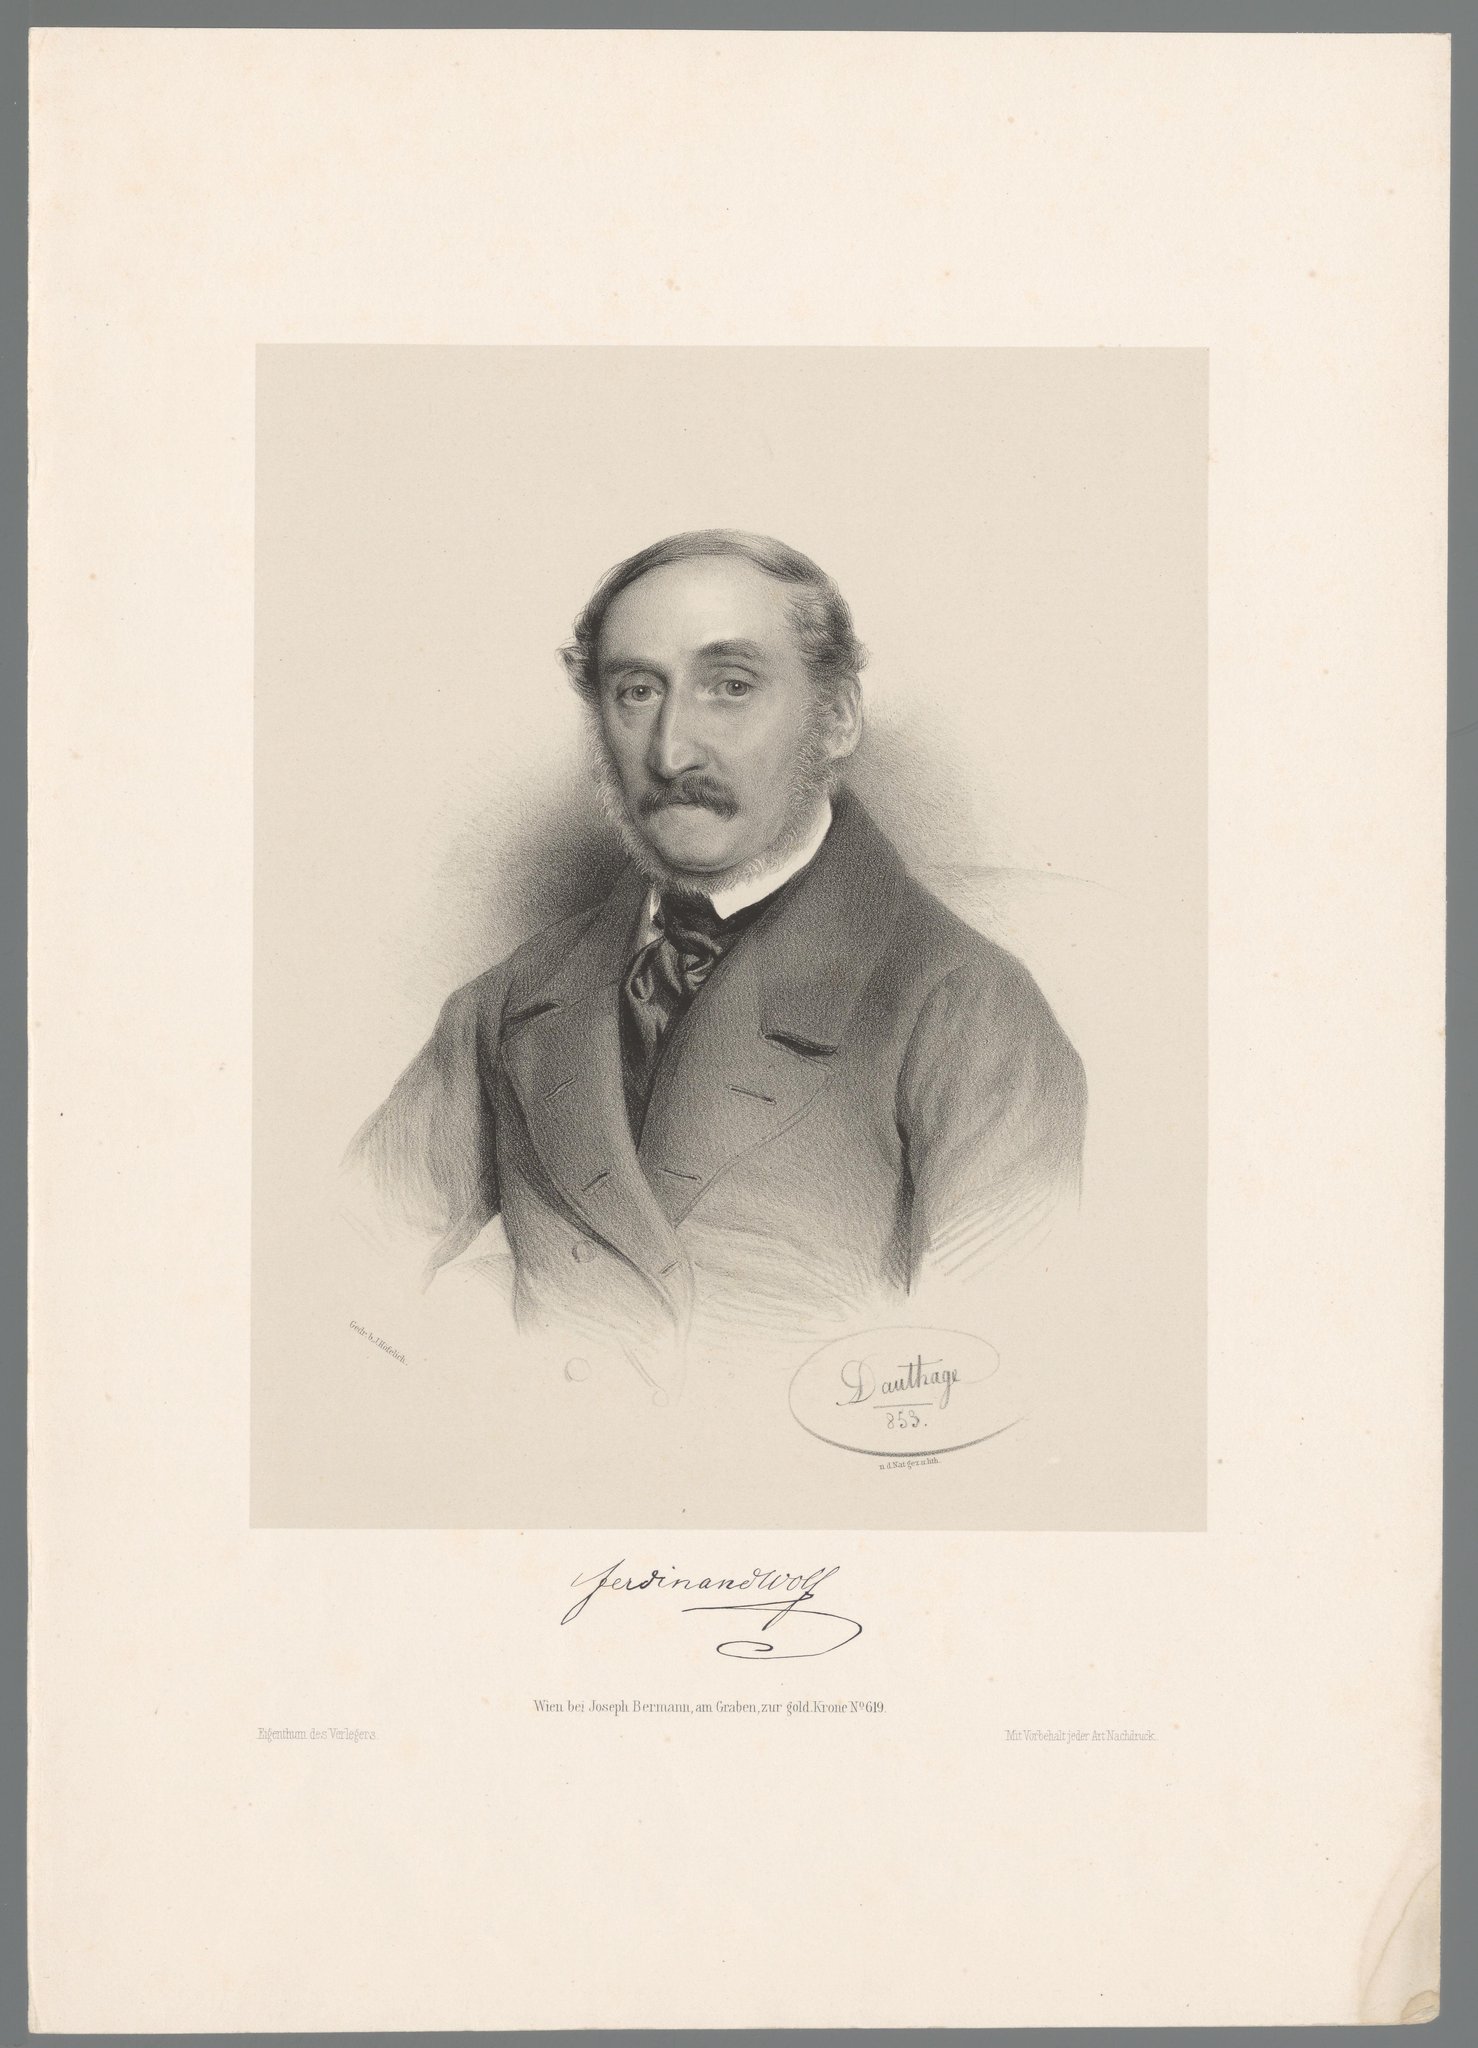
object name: print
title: Portret van Ferdinand Wolf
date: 1853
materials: paper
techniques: lithograph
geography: vienna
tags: vienna, historical persons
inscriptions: collector's mark: Lugt 2228